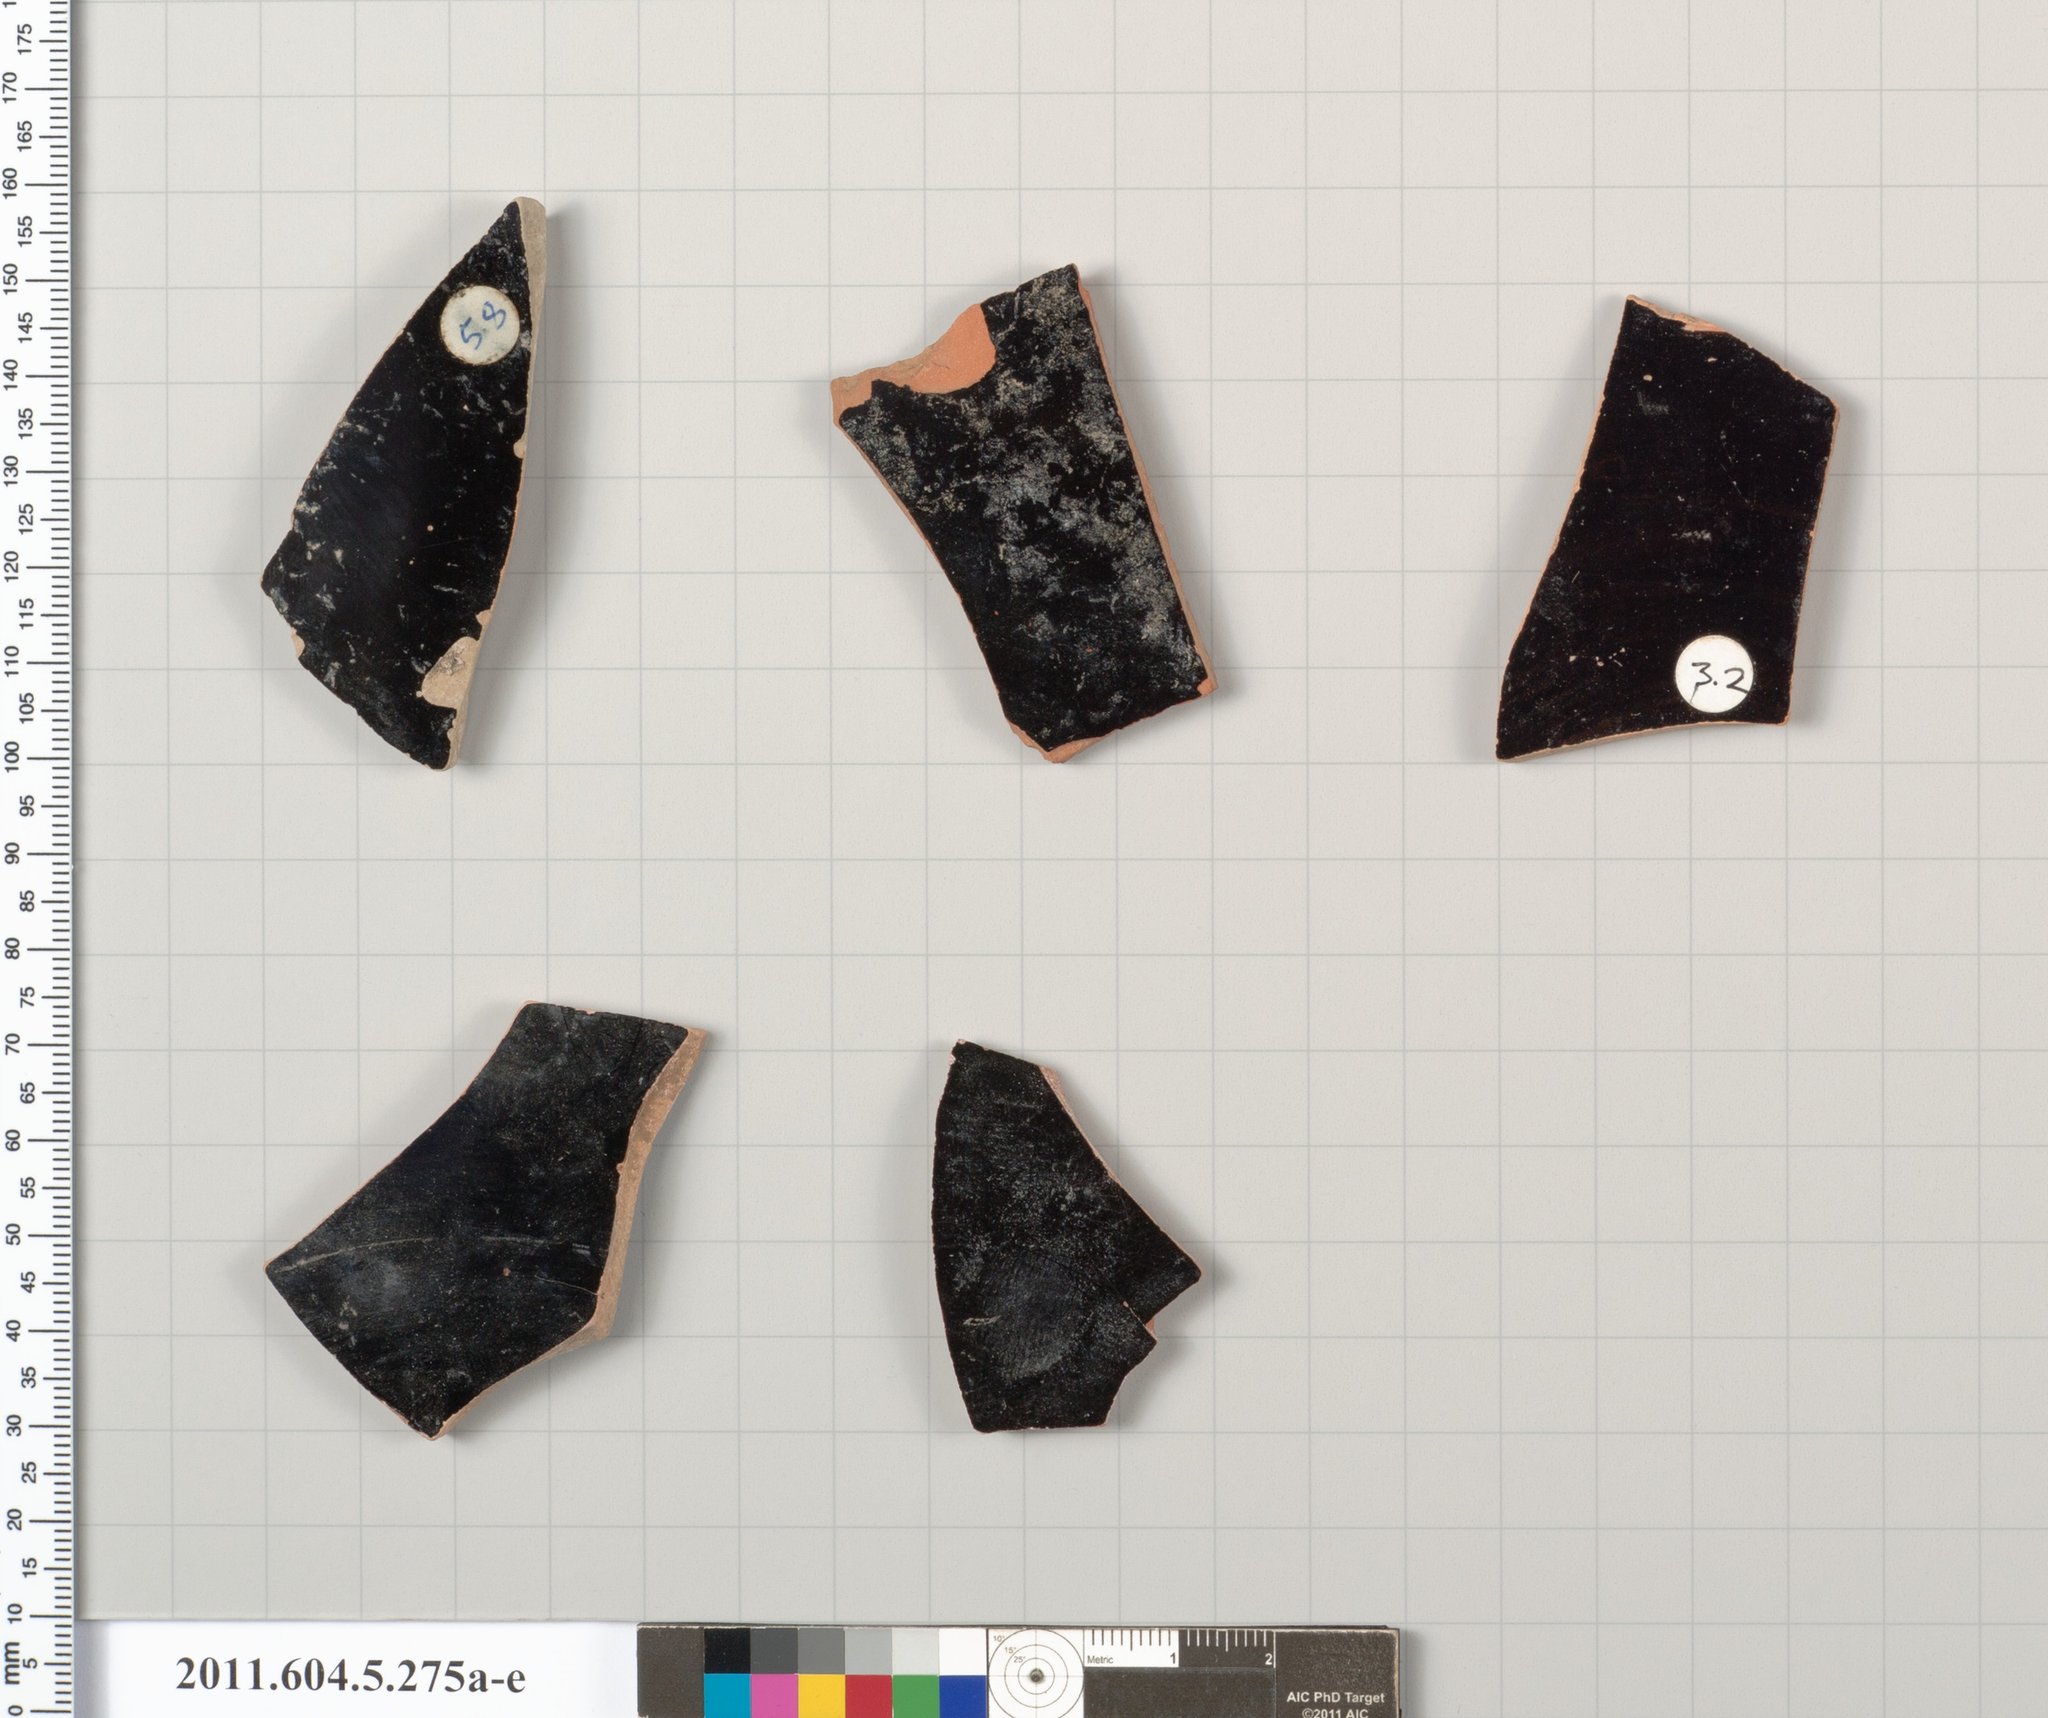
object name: kylix fragment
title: Terracotta fragments of kylikes (drinking cups)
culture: greek, attic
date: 600-401 BCE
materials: terracotta